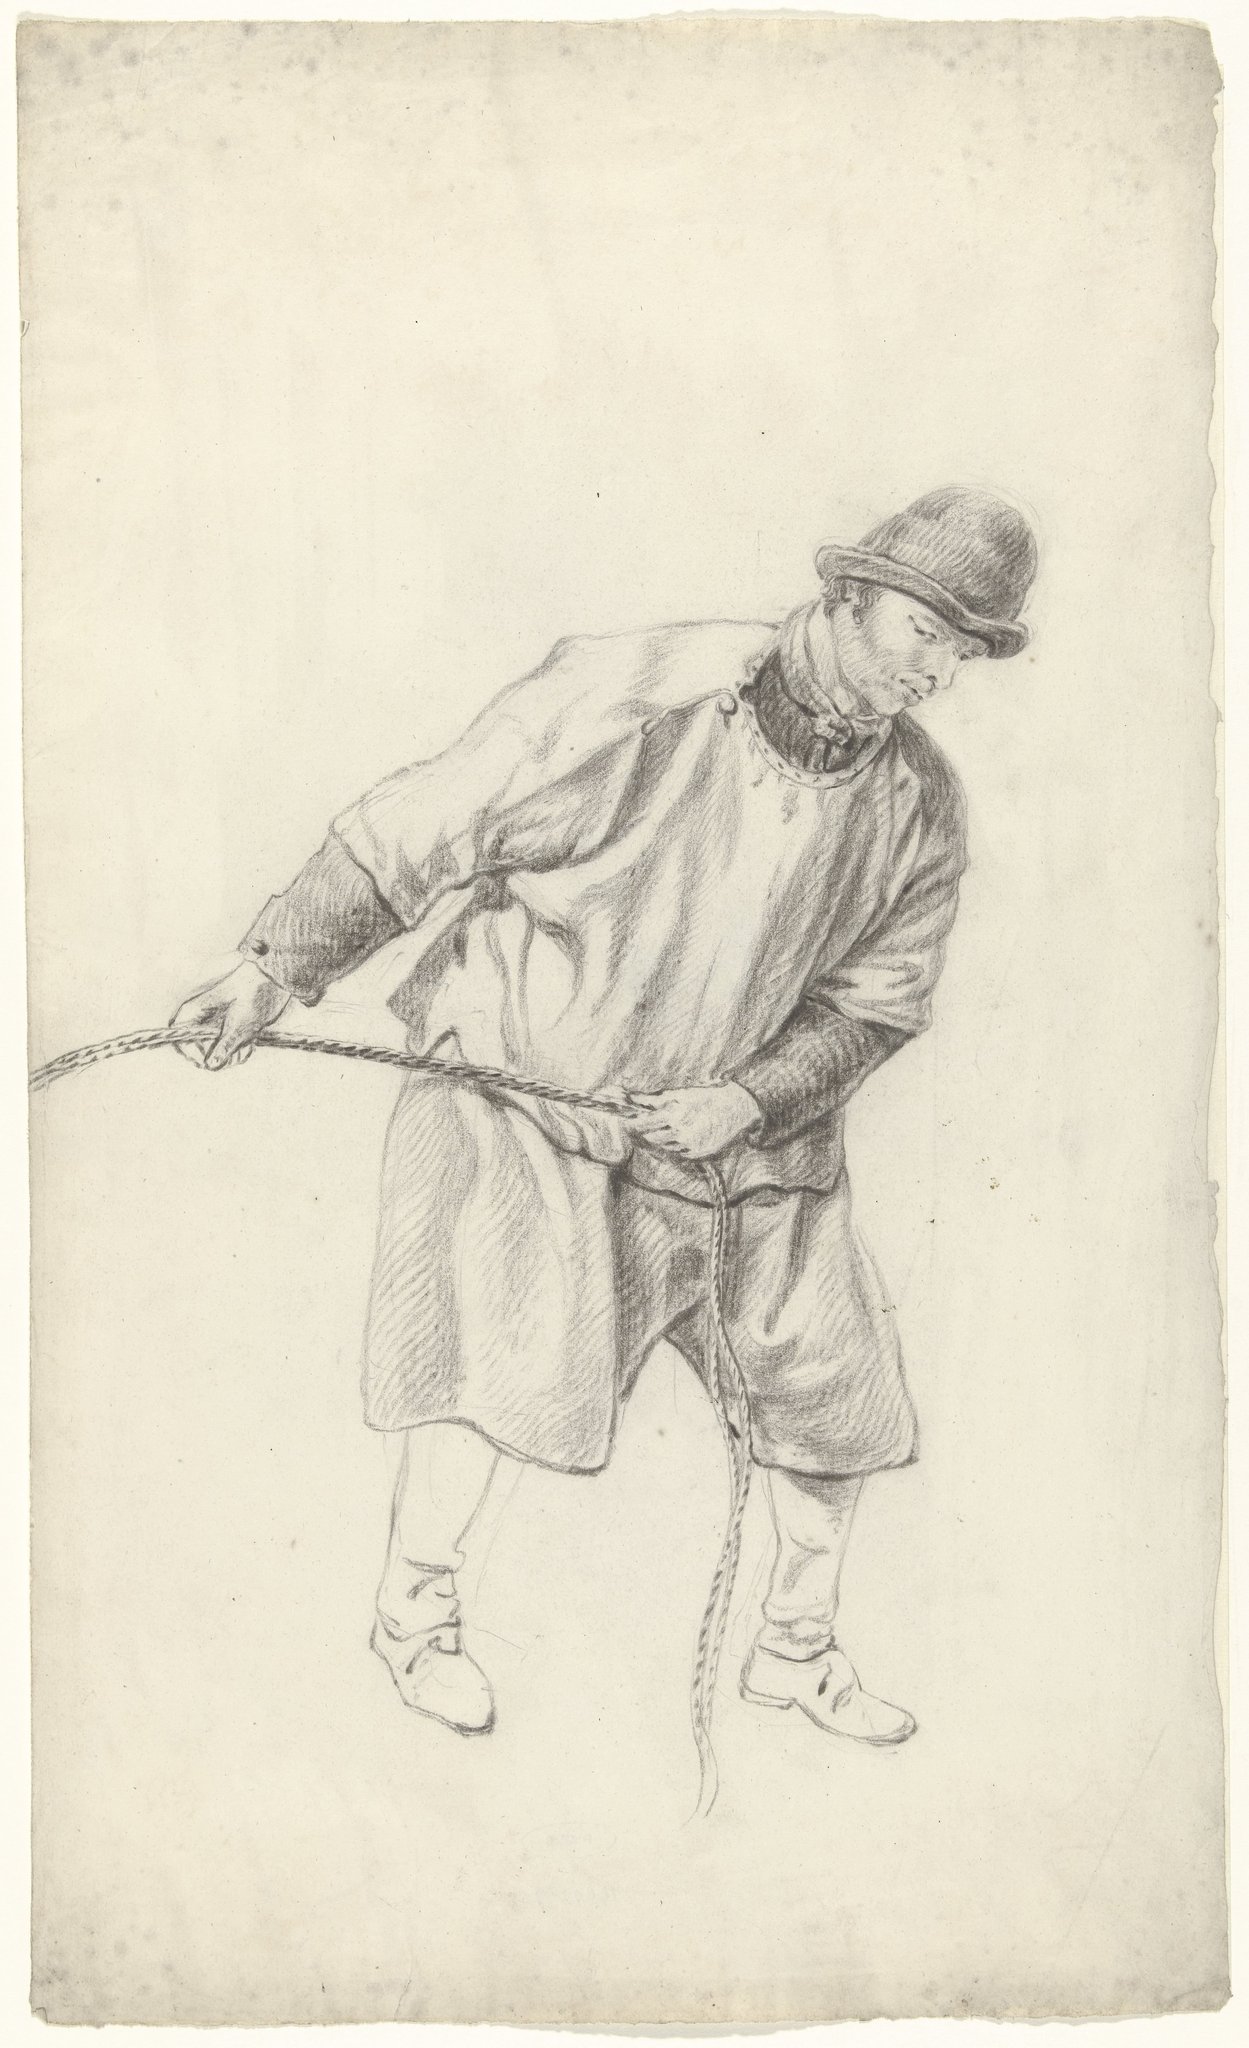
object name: drawing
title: Staande man, trekkend aan een touw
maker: Anonymous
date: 1700-1800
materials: chalk, paper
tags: drawing, pulling something, standing figure